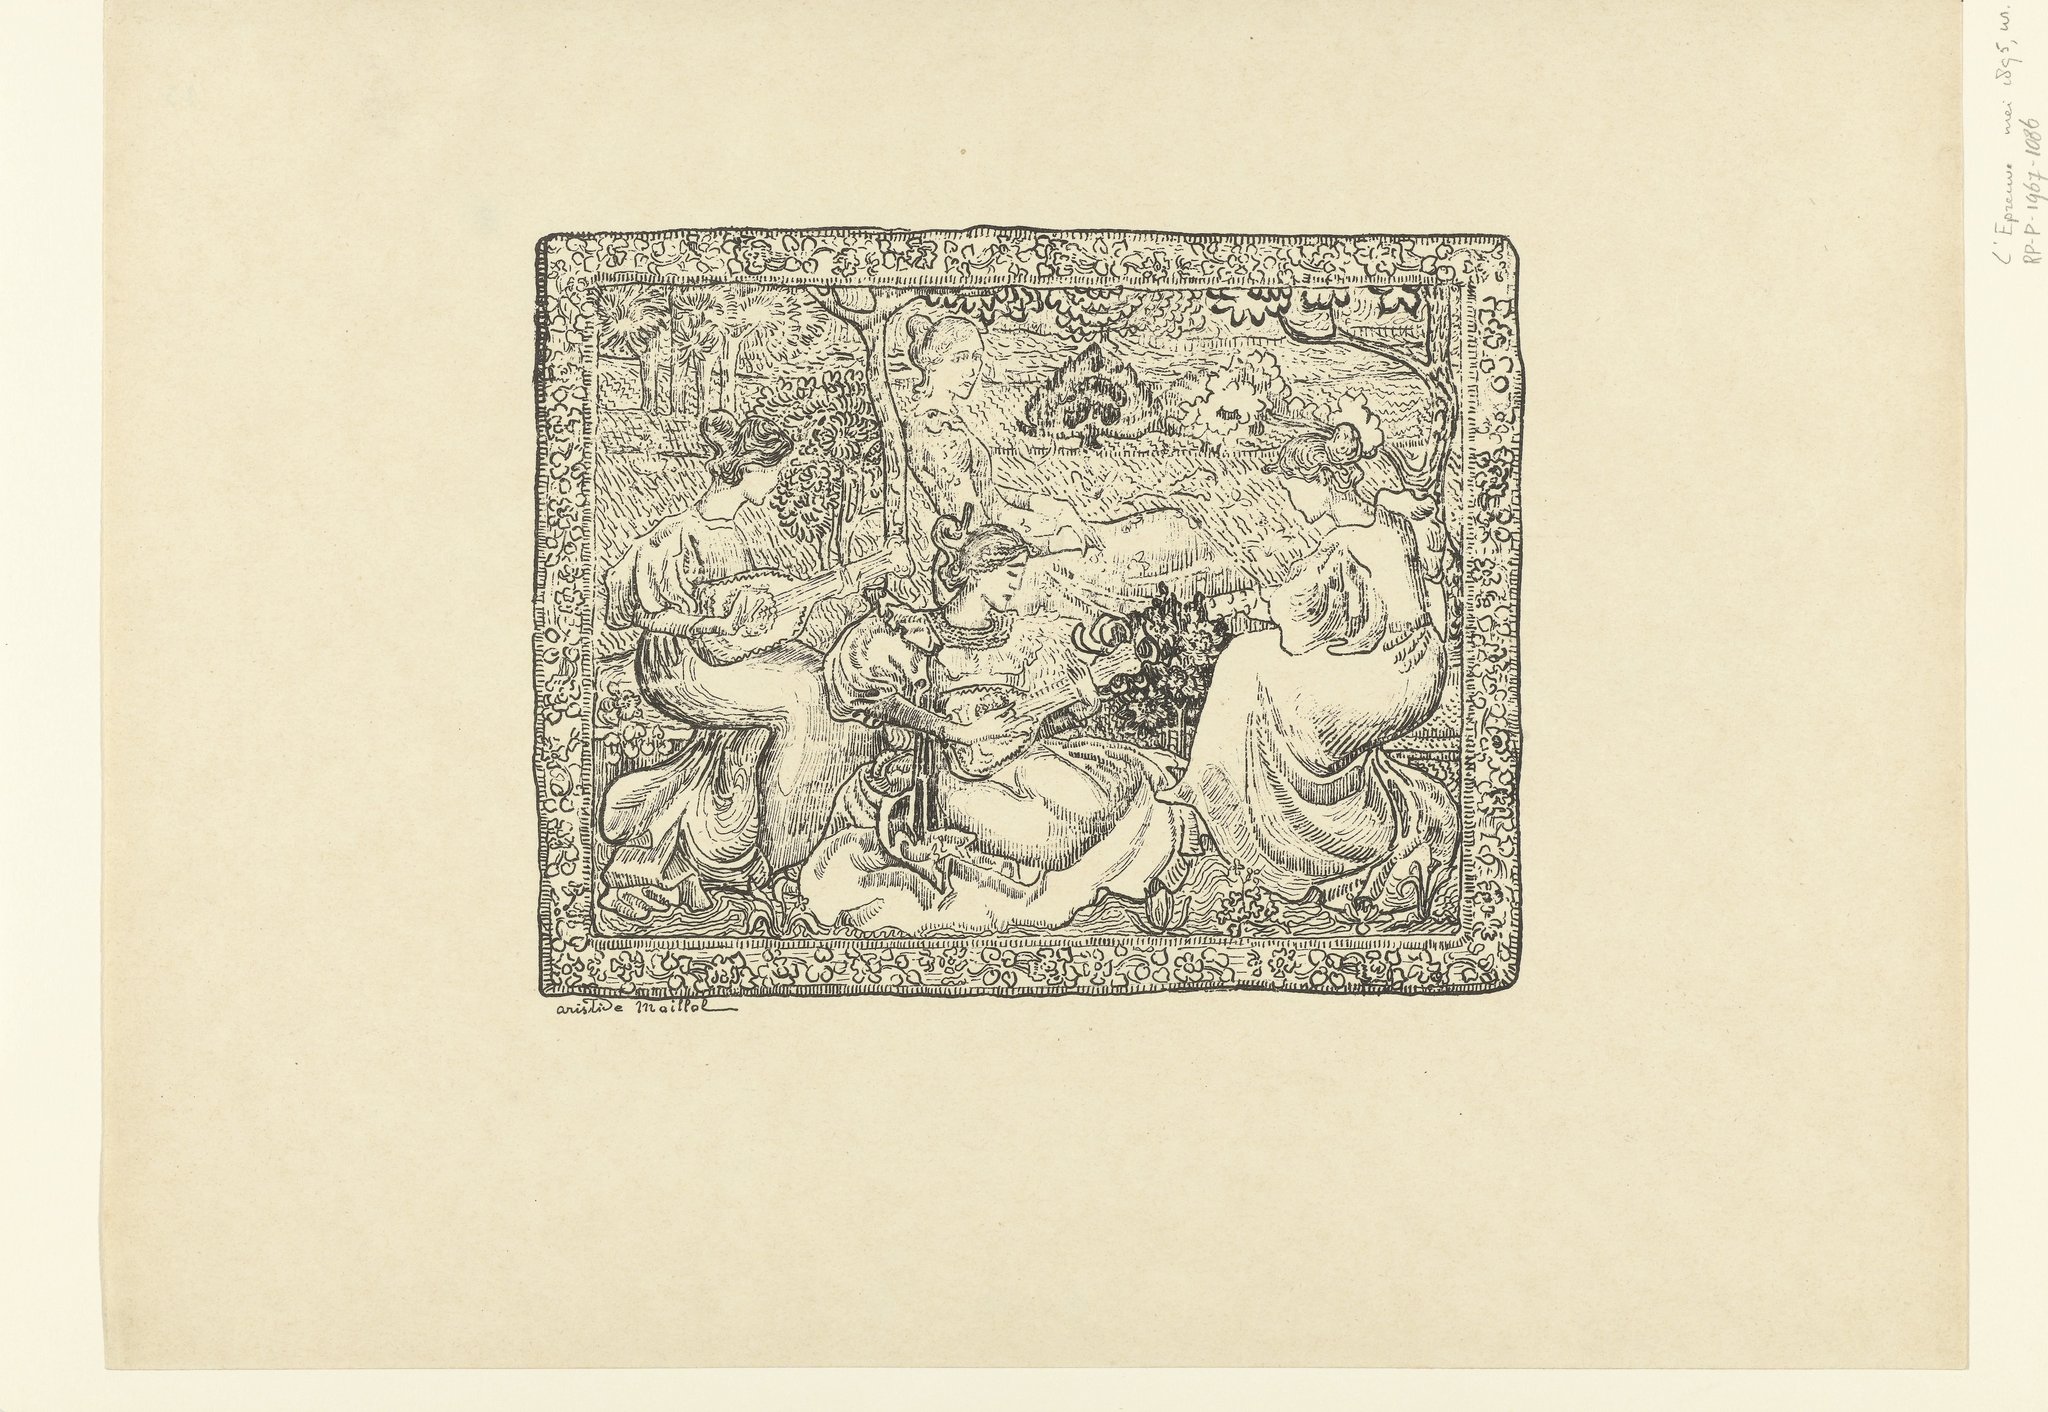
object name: print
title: Tapisserie ou concert champêtre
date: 1805-1895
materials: paper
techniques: lithograph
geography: paris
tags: carpet, rug, lute, and special forms of lute, e.g.: theorbo, more than one musician with instrument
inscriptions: collector's mark: Lugt 2228, collector's mark: Lugt 2760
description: Verschenen in album met elf originele prenten als supplement bij tijdschrift: L'Epreuve, mei 1895, prent nr. 6